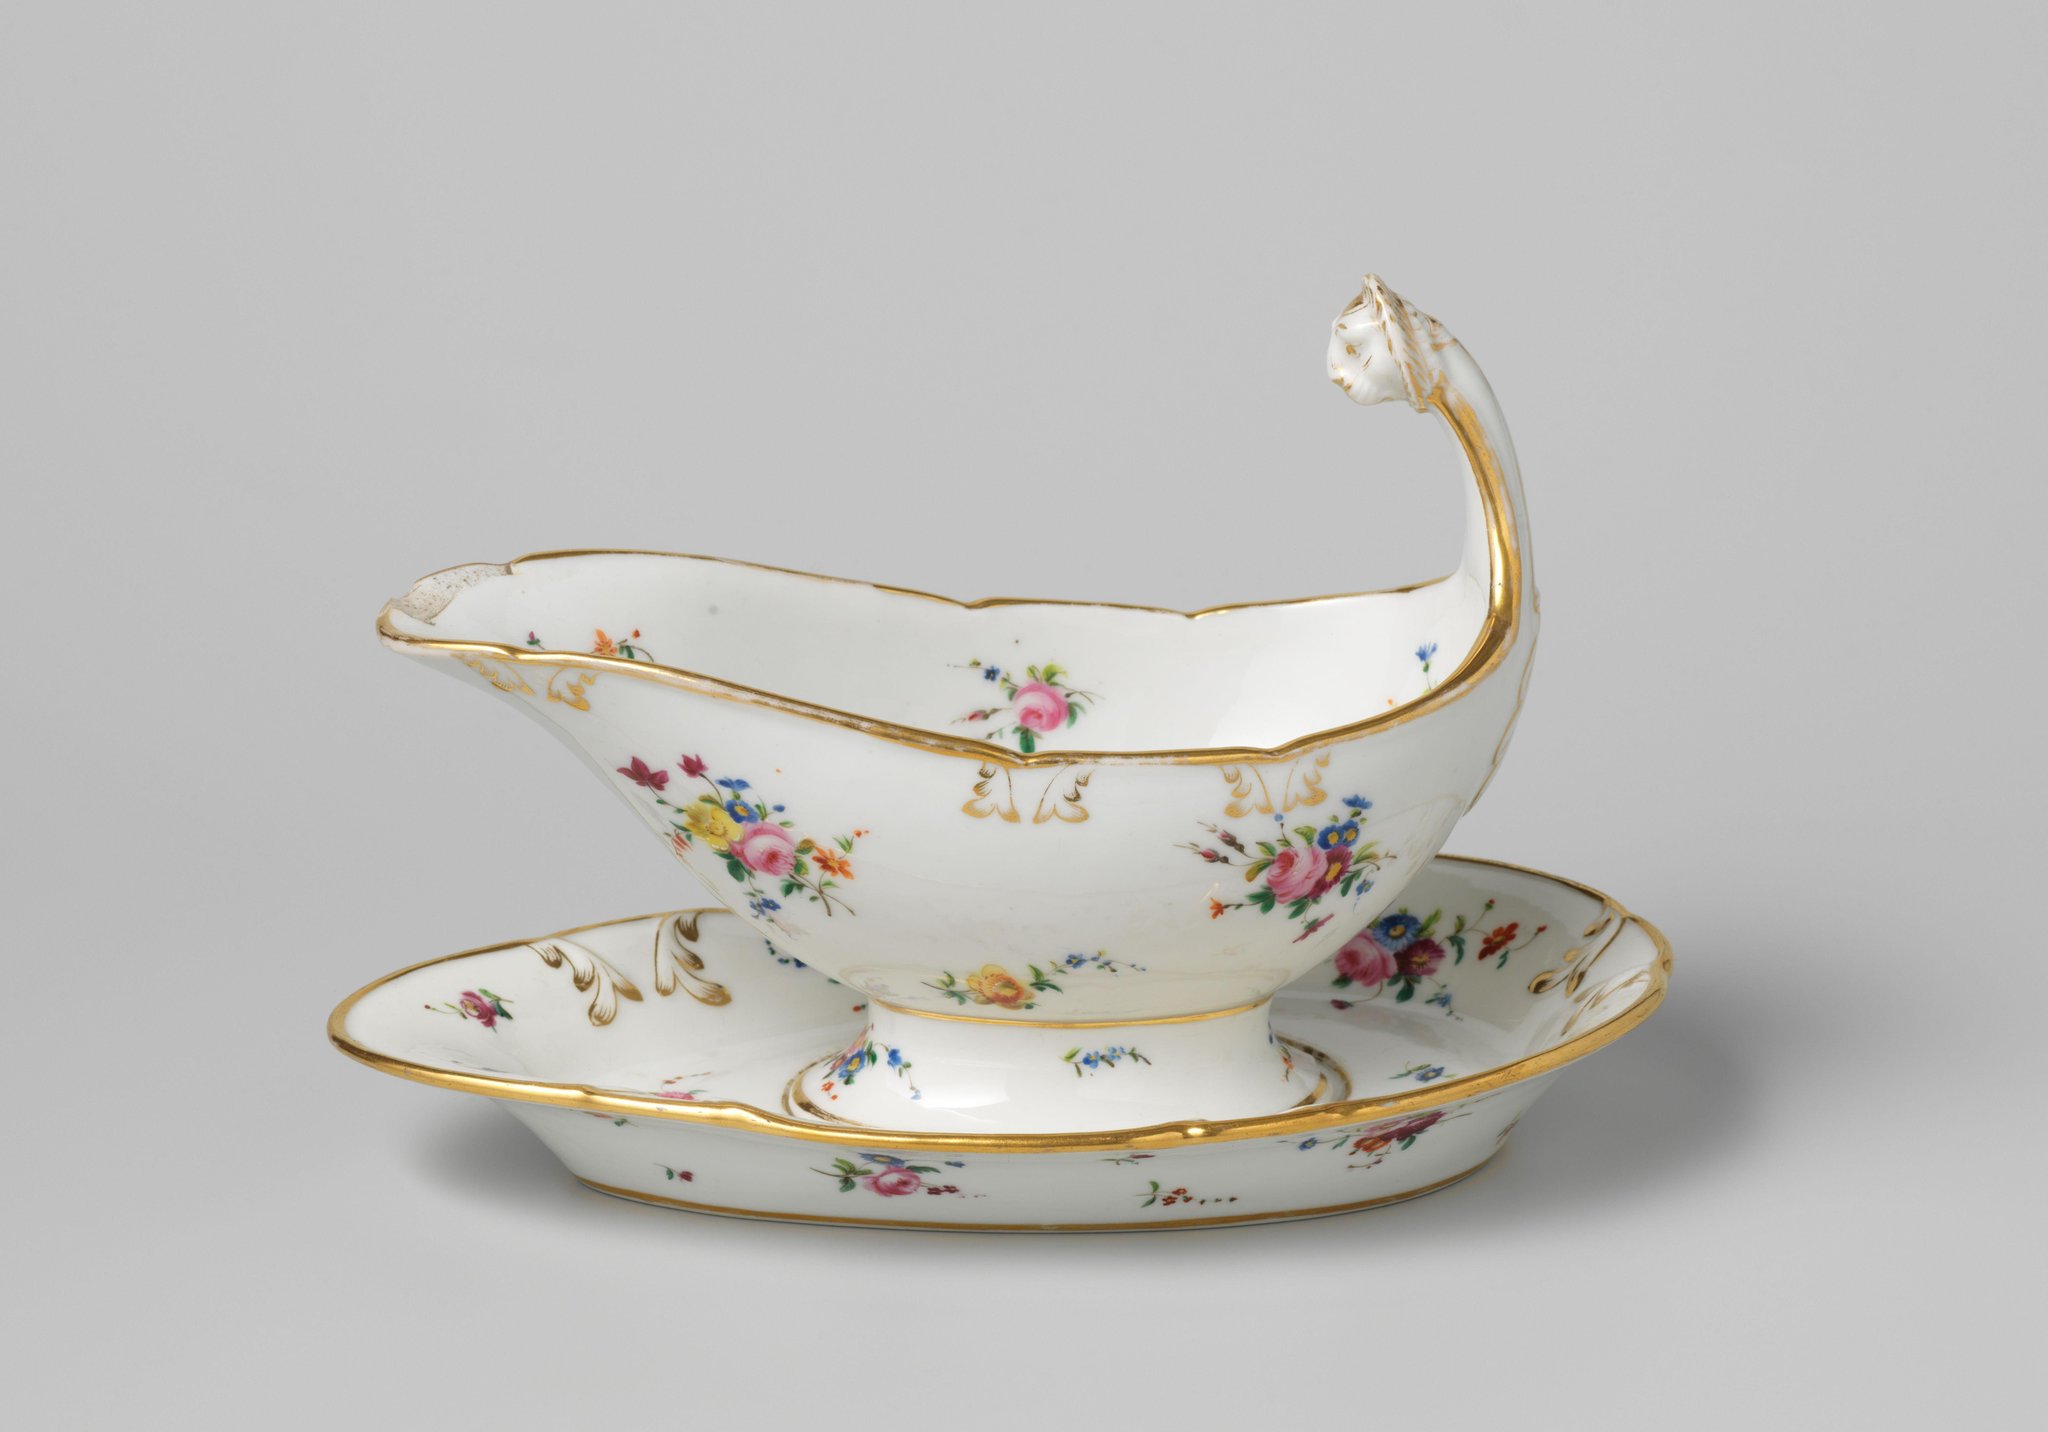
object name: sauceboat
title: Saus bowl on dish with bouquets and flower sprays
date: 1839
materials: glaze, gold, paint, porcelain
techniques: firing, forming, gilding, turning, vitrification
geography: paris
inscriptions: mark: ‘DENUELLE/ Boulevard St. Denis 18/ à Paris’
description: Sauskom op schotel van porselein met een gelobde rand, beschilderd op het glazuur in blauw, rood, roze, groen, geel, paars, zwart en goud. De kom is ovaal, op een hoge, spreidende voet en met aan de ene zijde vanuit de rand een handvat eindigend in een leeuwenkop en aan de andere zijde een brede schenkrand. De schaal is ovaal met en een zijde spits toelopend. Versierd met verschillende bloemen en strooibloemen. Vanuit de gelobde, gouden rand, bladranken in goud. Gouden lijn boven de voet. Schotel gemerkt op de onderzijde met 'DENUELLE/ Boulevard St. Denis 18/ à Paris'. Rand van de kom beschadigd.